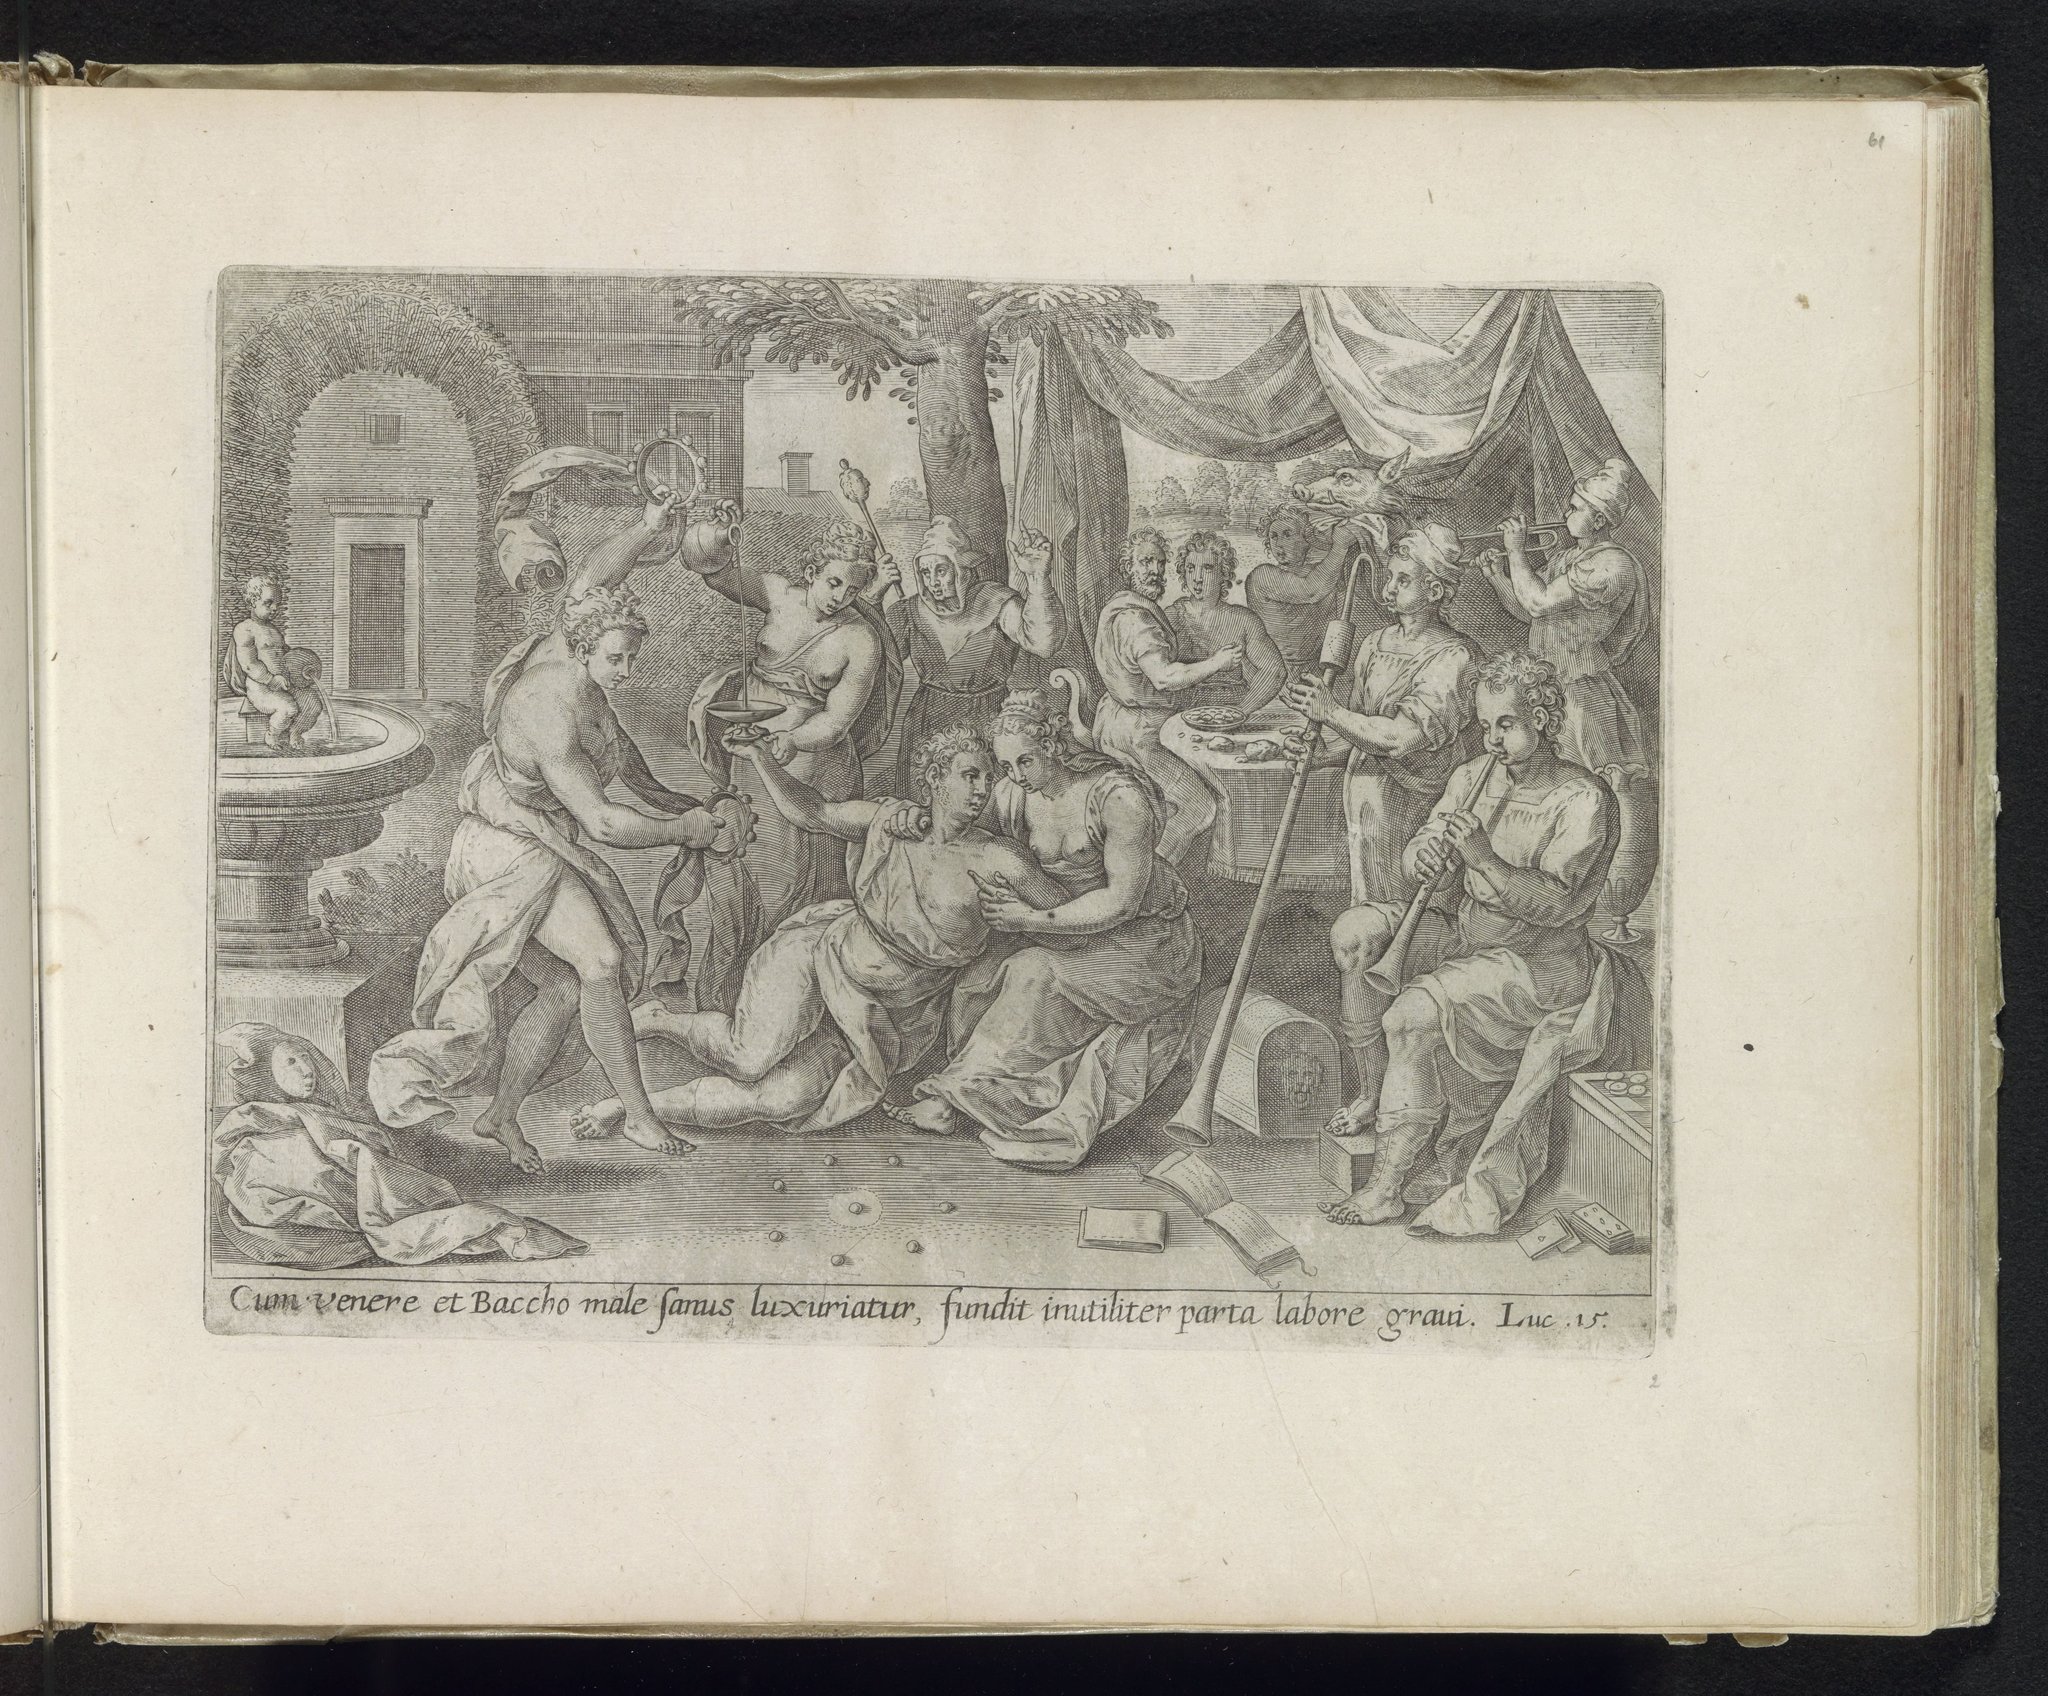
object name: print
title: De verloren zoon verkwist zijn erfenis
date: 1585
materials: paper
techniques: engraving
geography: antwerp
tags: small group of musicians, chamber orchestra, jazz band, court jester, court fool, wind instruments, the prodigal son in the midst of prostitutes feasting and dissipating his patrimony, usually in a brothel or inn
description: De verloren zoon verkwist zijn erfenis in een bordeel. In een tuin wordt hij omarmd door een prostituee. Een andere vrouw schenkt zijn glas vol. Links een dansende vrouw met tamboerijnen en rechts een orkest. Achter de verloren zoon staat een nar. Onder de voorstelling een verwijzing in het Latijn naar de Bijbeltekst in Luc. 15. Deze prent maakt deel uit van een album.